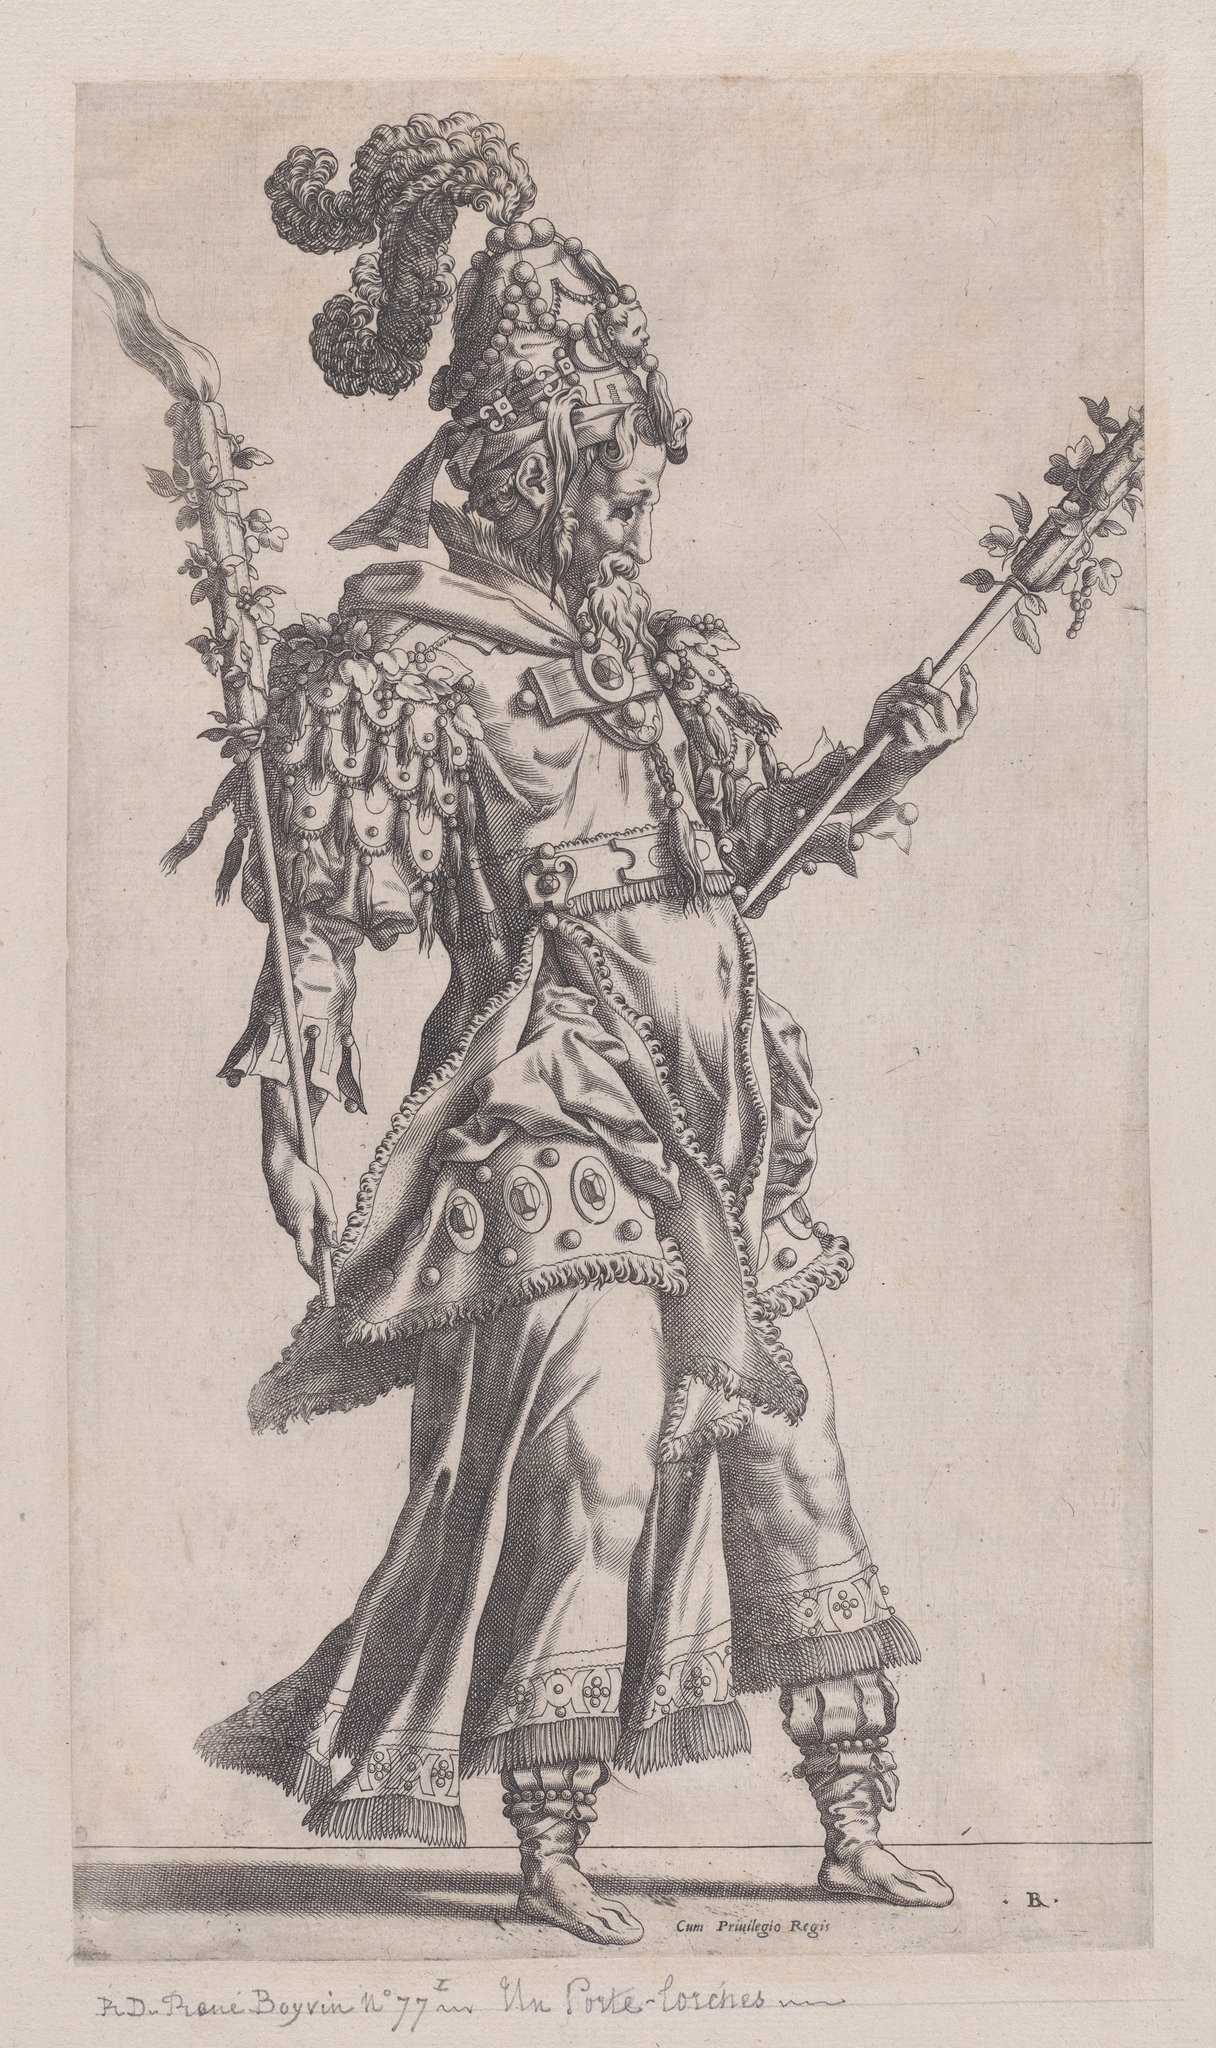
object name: print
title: Torch Bearer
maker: rené boyvin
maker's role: artist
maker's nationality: french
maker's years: 1525-1598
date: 1525-1600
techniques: engraving